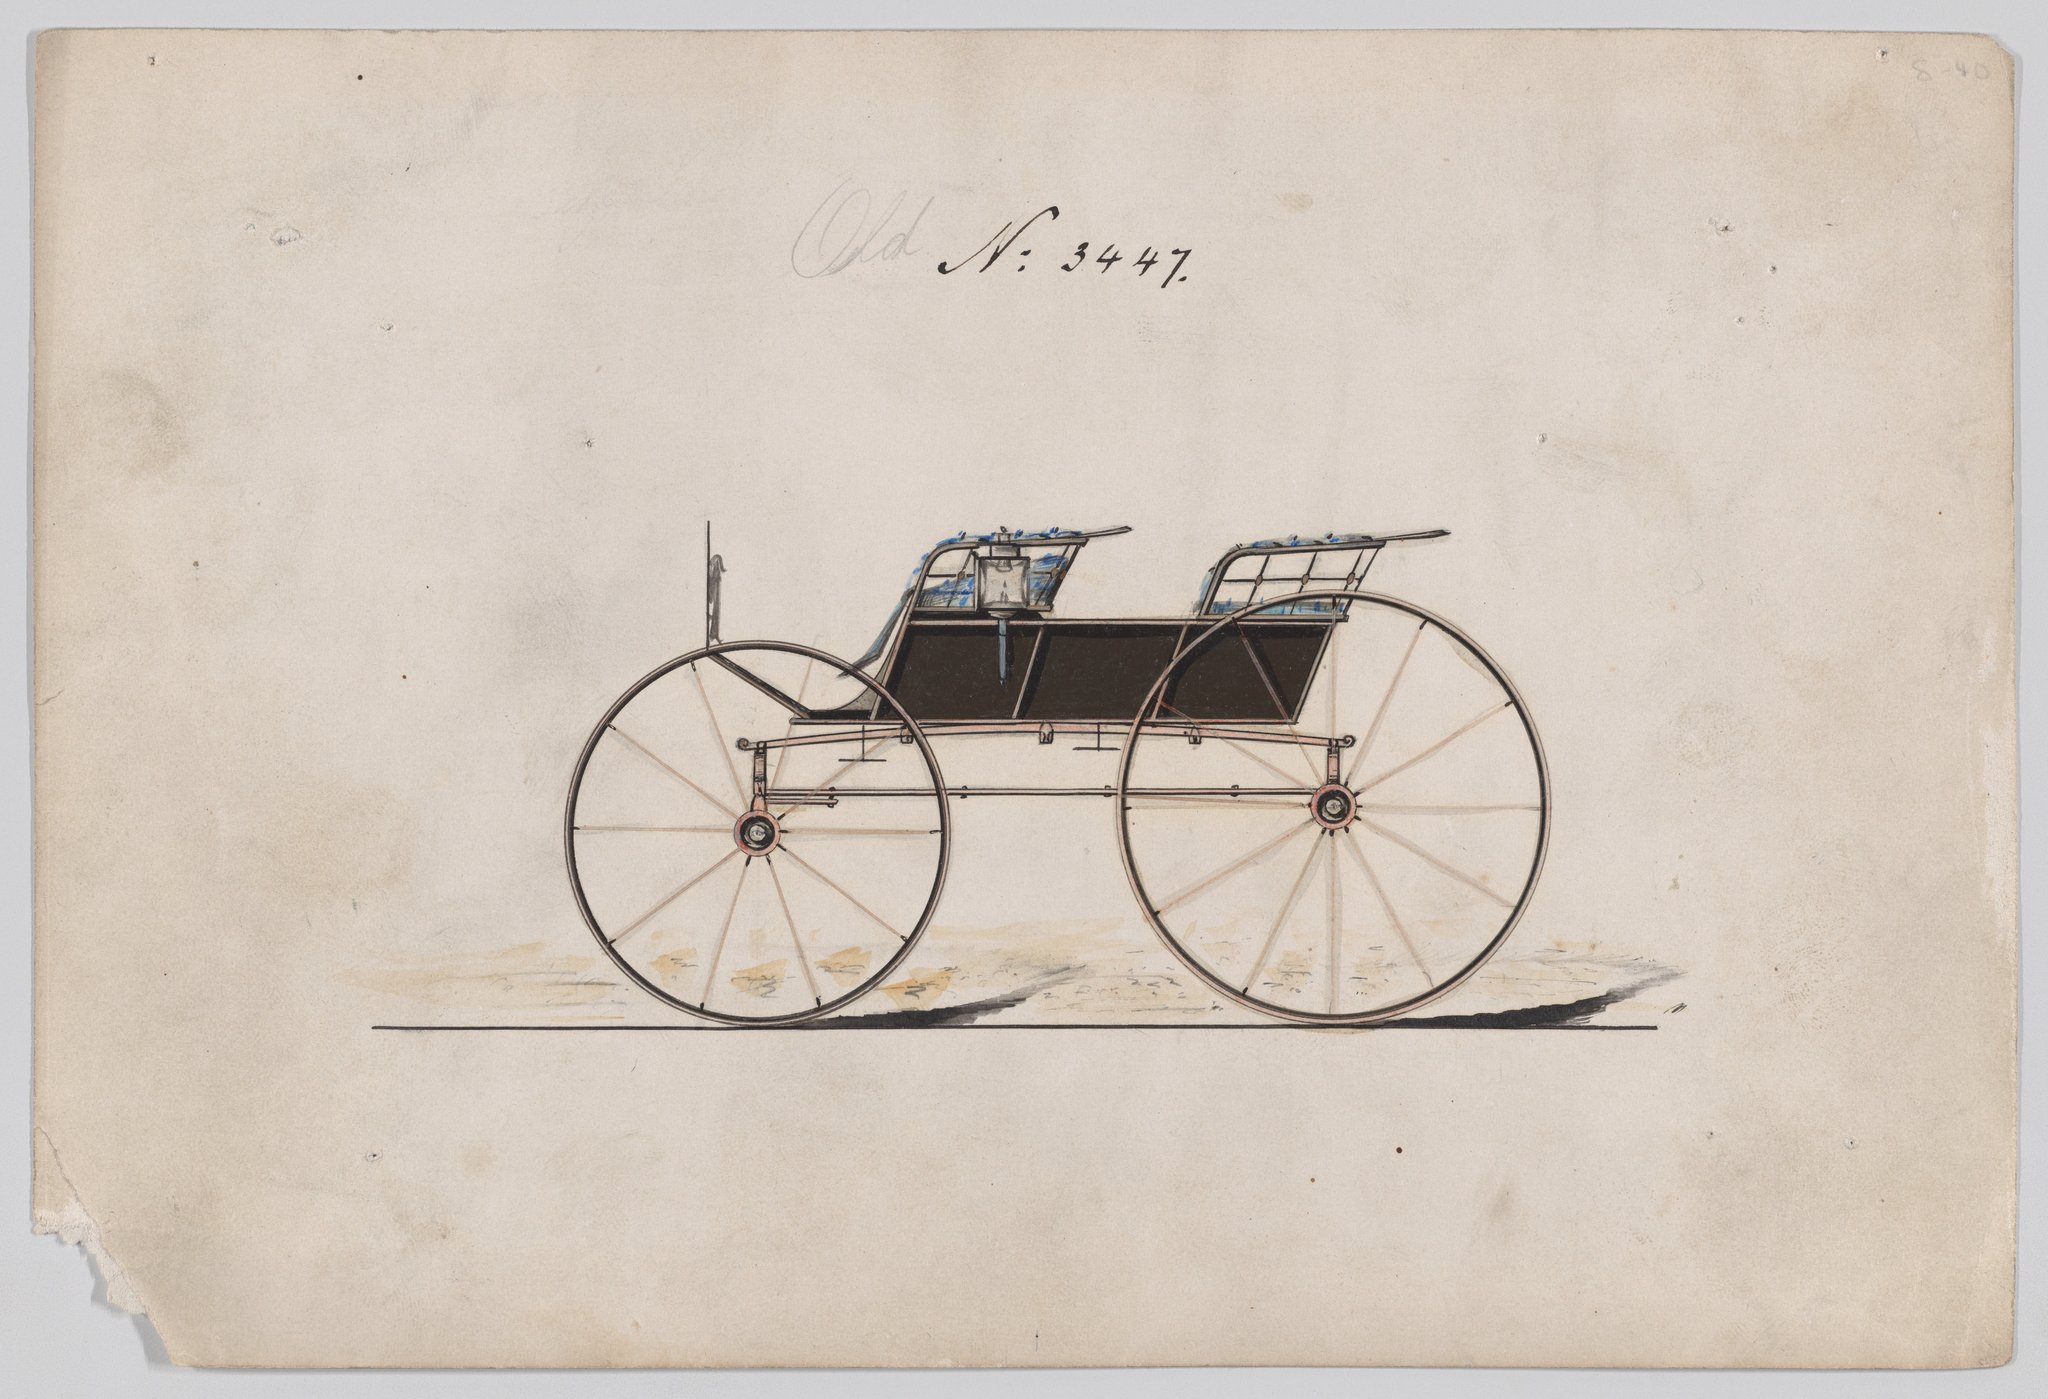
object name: drawing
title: Design for 4 seat Phaeton, no top, no. 3447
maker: brewster & co.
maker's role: manufacturer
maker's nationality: american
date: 1878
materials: gouache, gum arabic, ink, watercolor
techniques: pen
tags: carriages